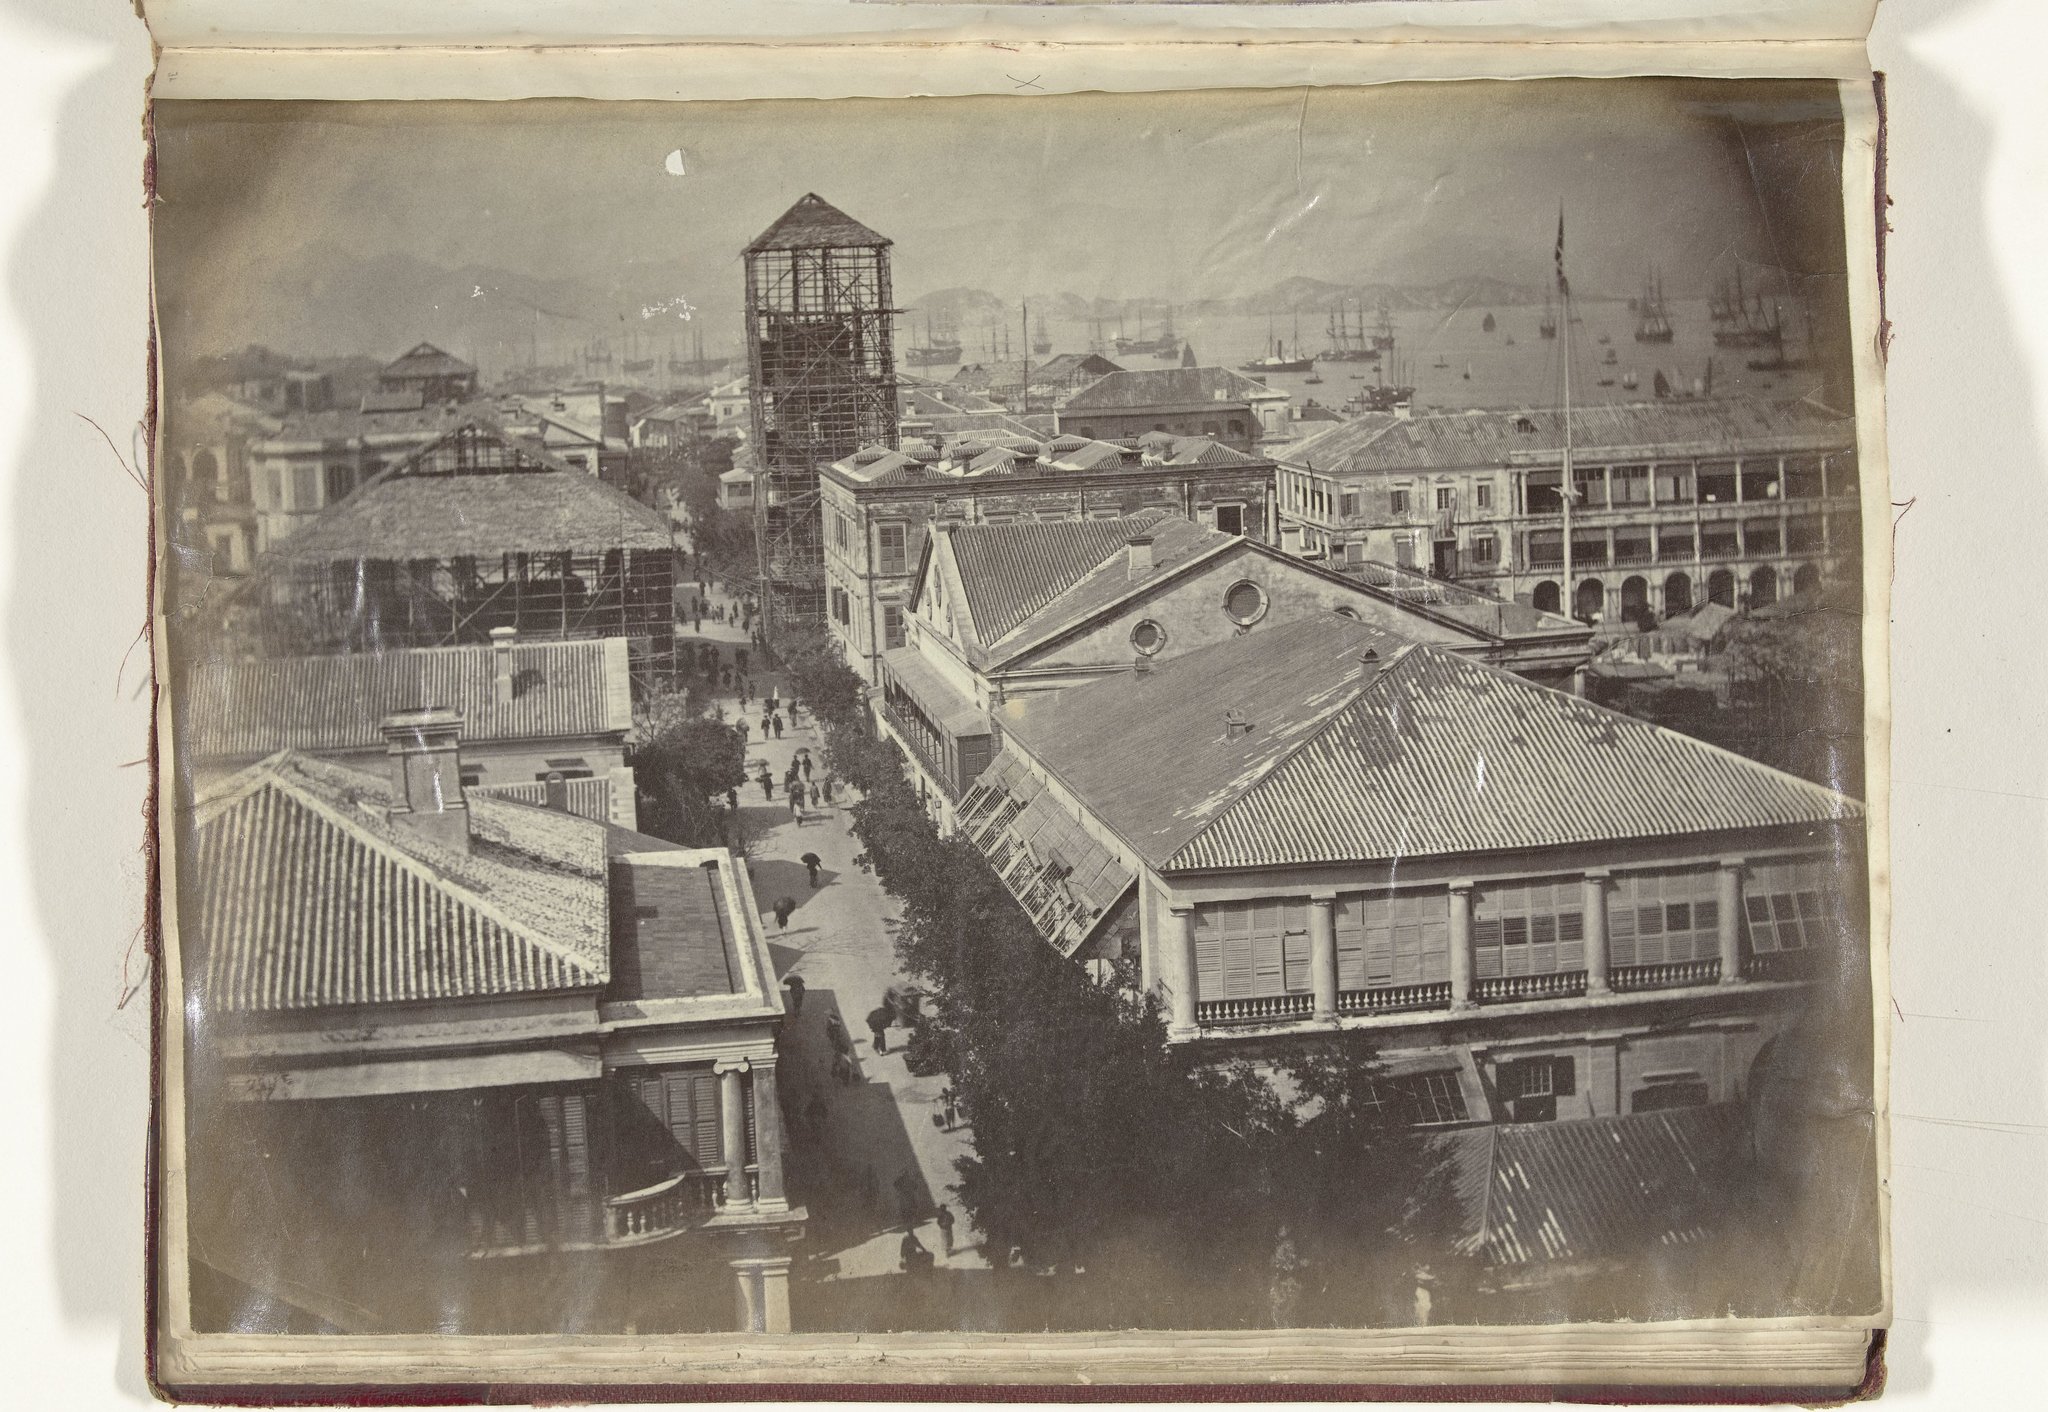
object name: album leaf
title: Straatgezicht in een havenstad, China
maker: Anonymous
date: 1879-1890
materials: paper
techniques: albumen print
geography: china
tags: harbour, street, china